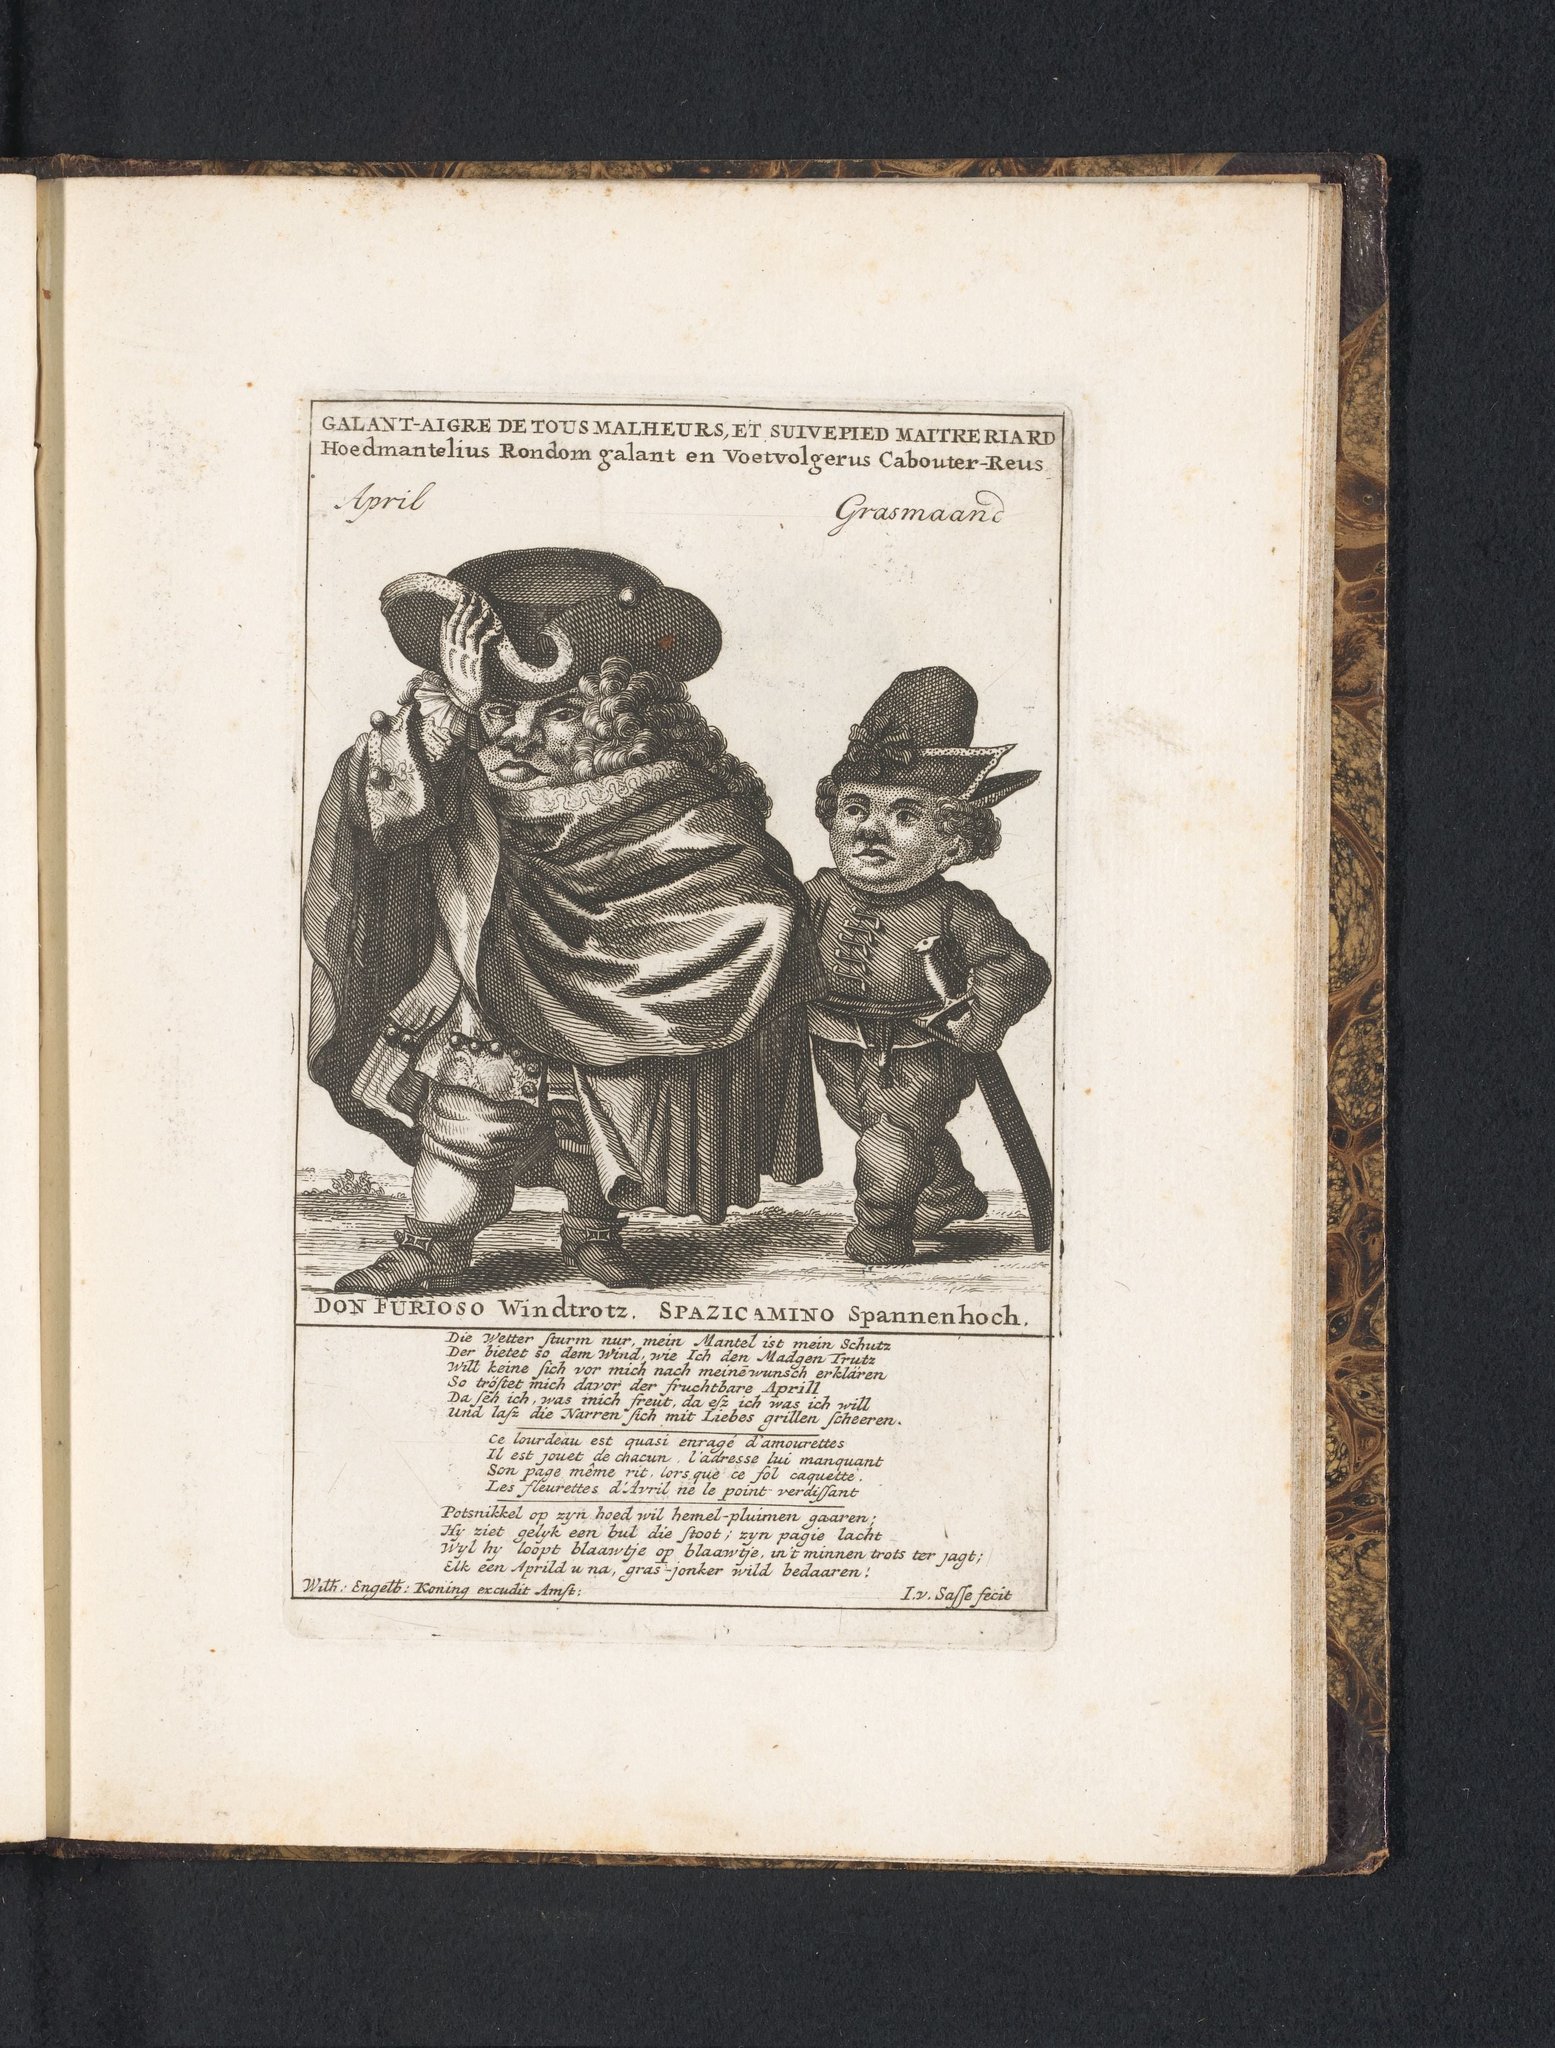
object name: print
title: Galant-aigre de tous malheurs, et suivepied maitre Riard / Hoedmantelius Rondom galant en Voetvolgerus Cabouter-Reus / Don Furioso Windtrotz. Spazicamino Spannenhoch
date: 1718-1720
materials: paper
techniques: engraving, etching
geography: amsterdam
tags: caricatures (human types), little people, april and its 'labours'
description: Twee kleine mensen voor de maand april (Grasmaand). Man in met hoed en mantel gevolgd door zijn voetknecht. In het onderschrift verzen in het Duits, Frans en Nederlands. Onderdeel van deel III (een serie van de twaalf maanden) in de tweede Nederlandse gebonden uitgave uit 1720 (en gerelateerd aan de Windhandel in dat jaar) van een serie karikaturen van kleine mensen, bekend als Het Dwergentooneel.